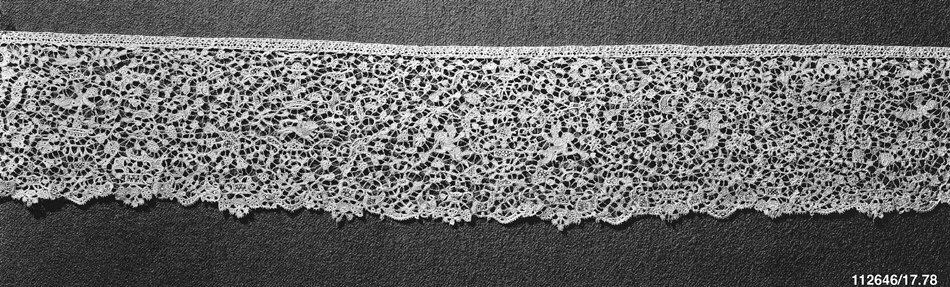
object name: fragment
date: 1667-1733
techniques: lace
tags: flowers,leaves